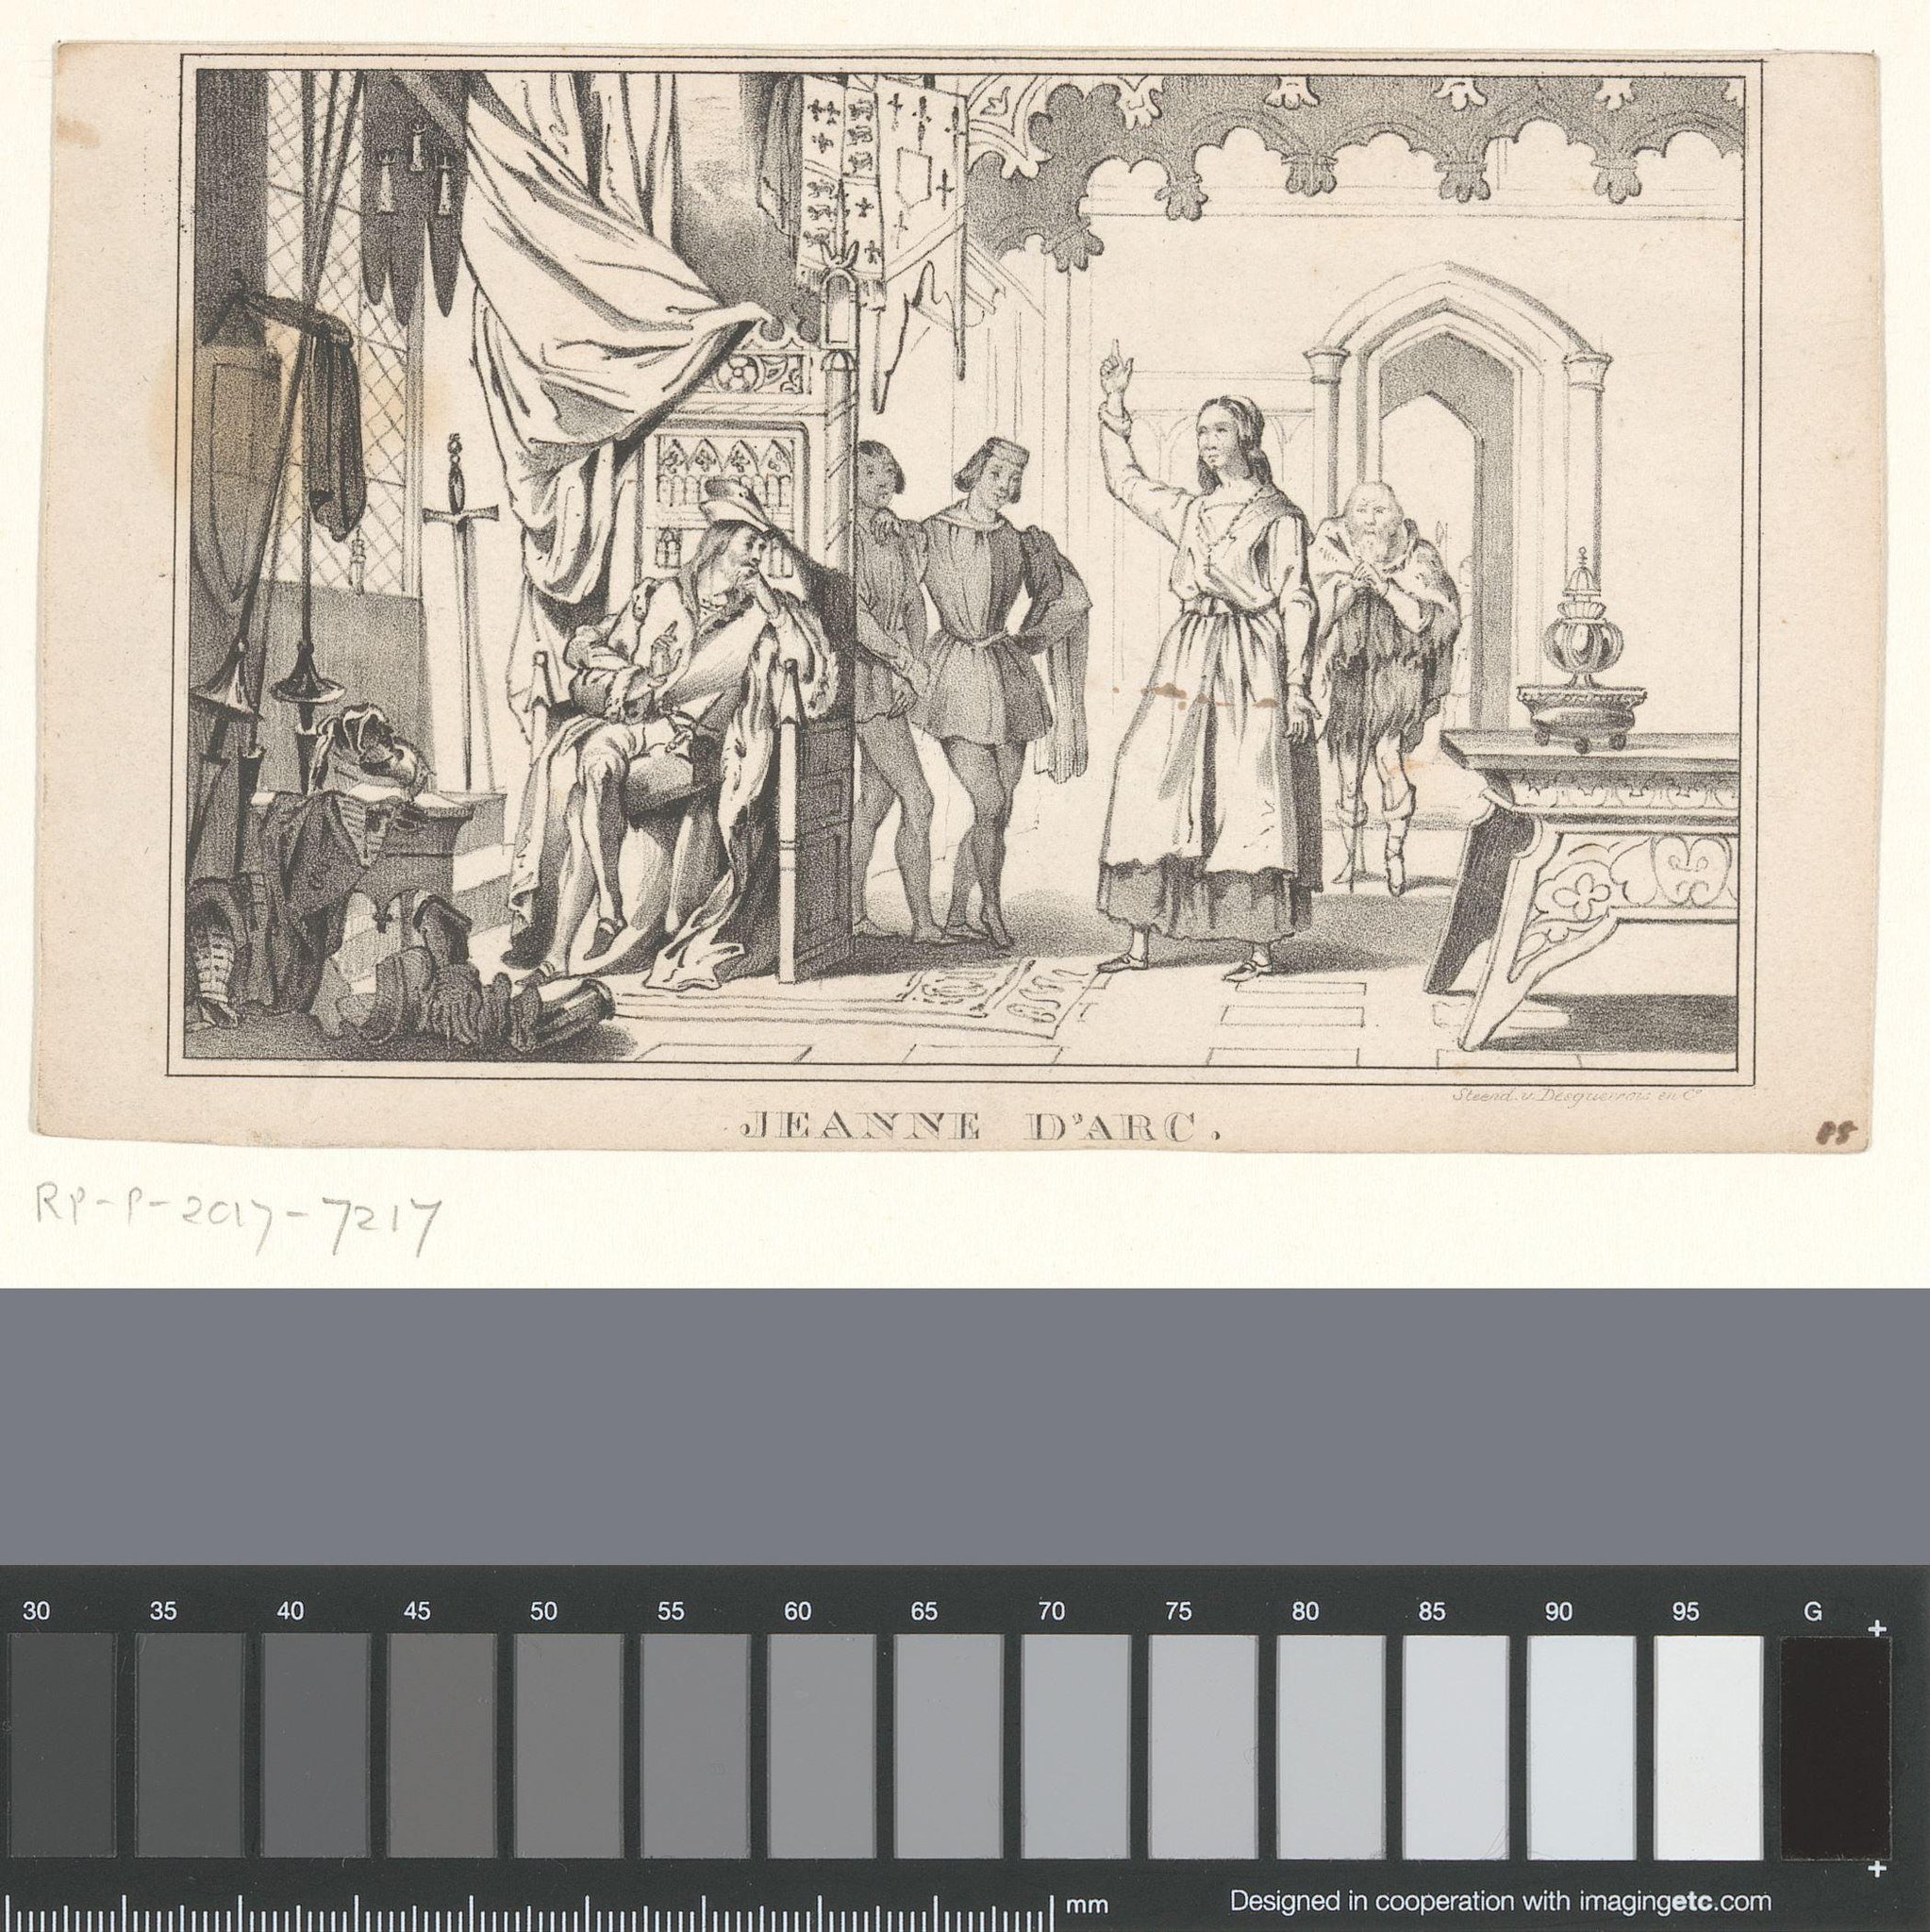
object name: print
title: Jeanne d'Arc bij de dauphin in Chinon, 1429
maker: Anonymous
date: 1827-1899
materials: paper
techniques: lithograph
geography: netherlands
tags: audition; ruler giving audience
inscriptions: collector's mark: Lugt 2228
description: Jeanne d'Arc overtuigt de dauphin in Chinon van haar missie, februari 1429.